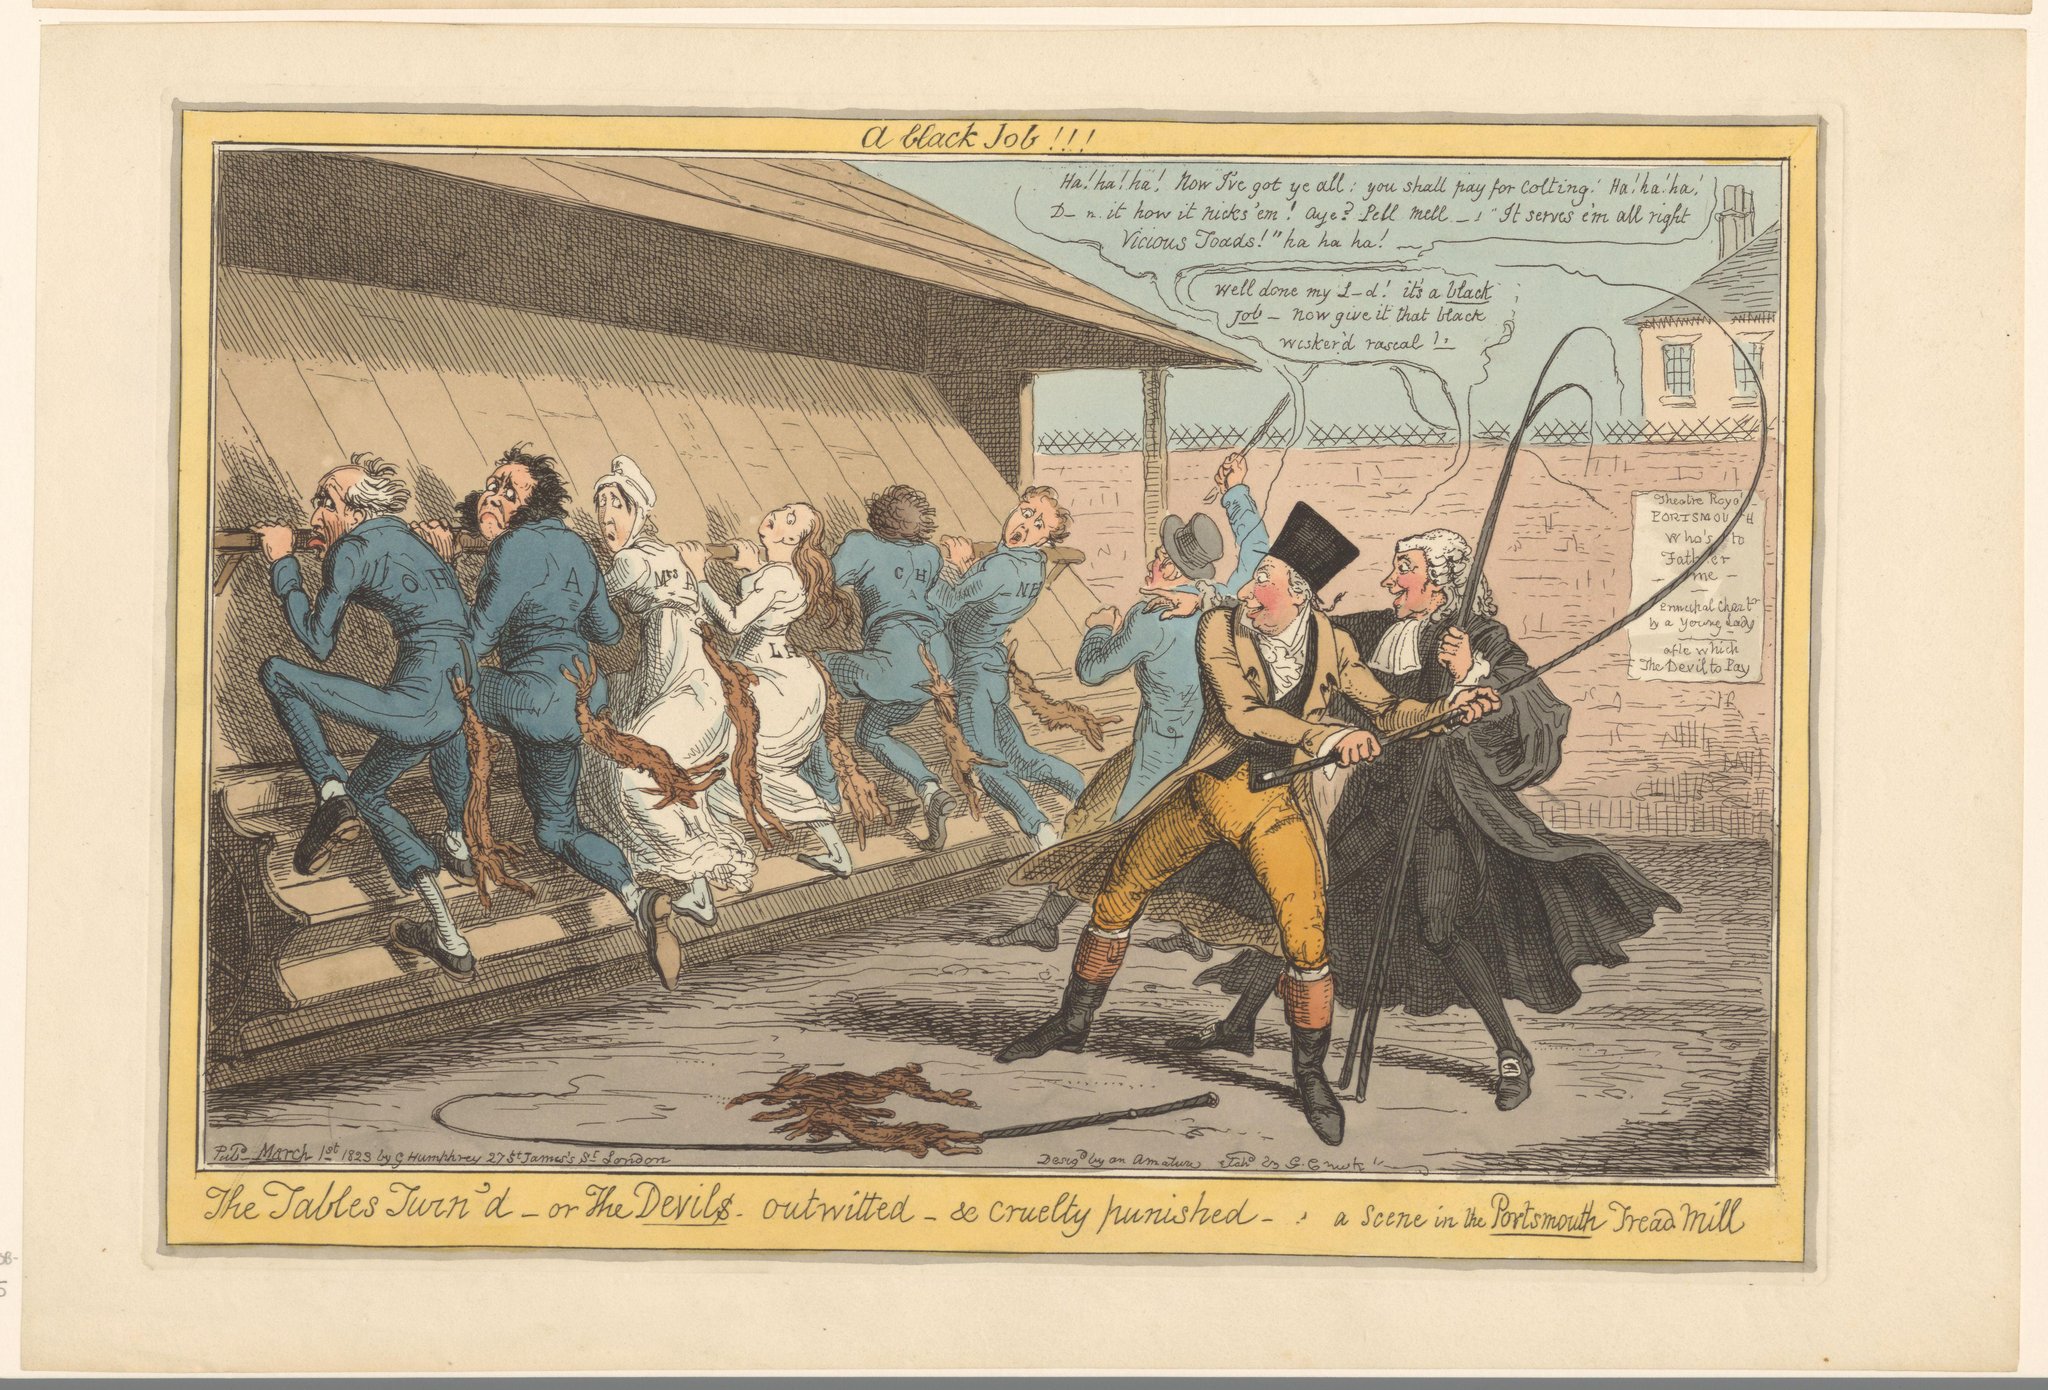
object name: cartoon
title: John Charles Wallop slaat vier mannen en twee vrouwen op een tredmolen met een zweep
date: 1803-1823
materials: paper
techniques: etching, hand coloring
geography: london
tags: torture, criminal law; punishment, adultery revenged, treadmill, rodents: rabbit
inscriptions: collector's mark: Lugt 2228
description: Spotprent op de in 1823 geestesziek verklaarde John Wallop, die wraak neemt op zes personen die hem slecht behandeld zouden hebben. Hij wordt bijgestaan door de advocaat Albert Pell.